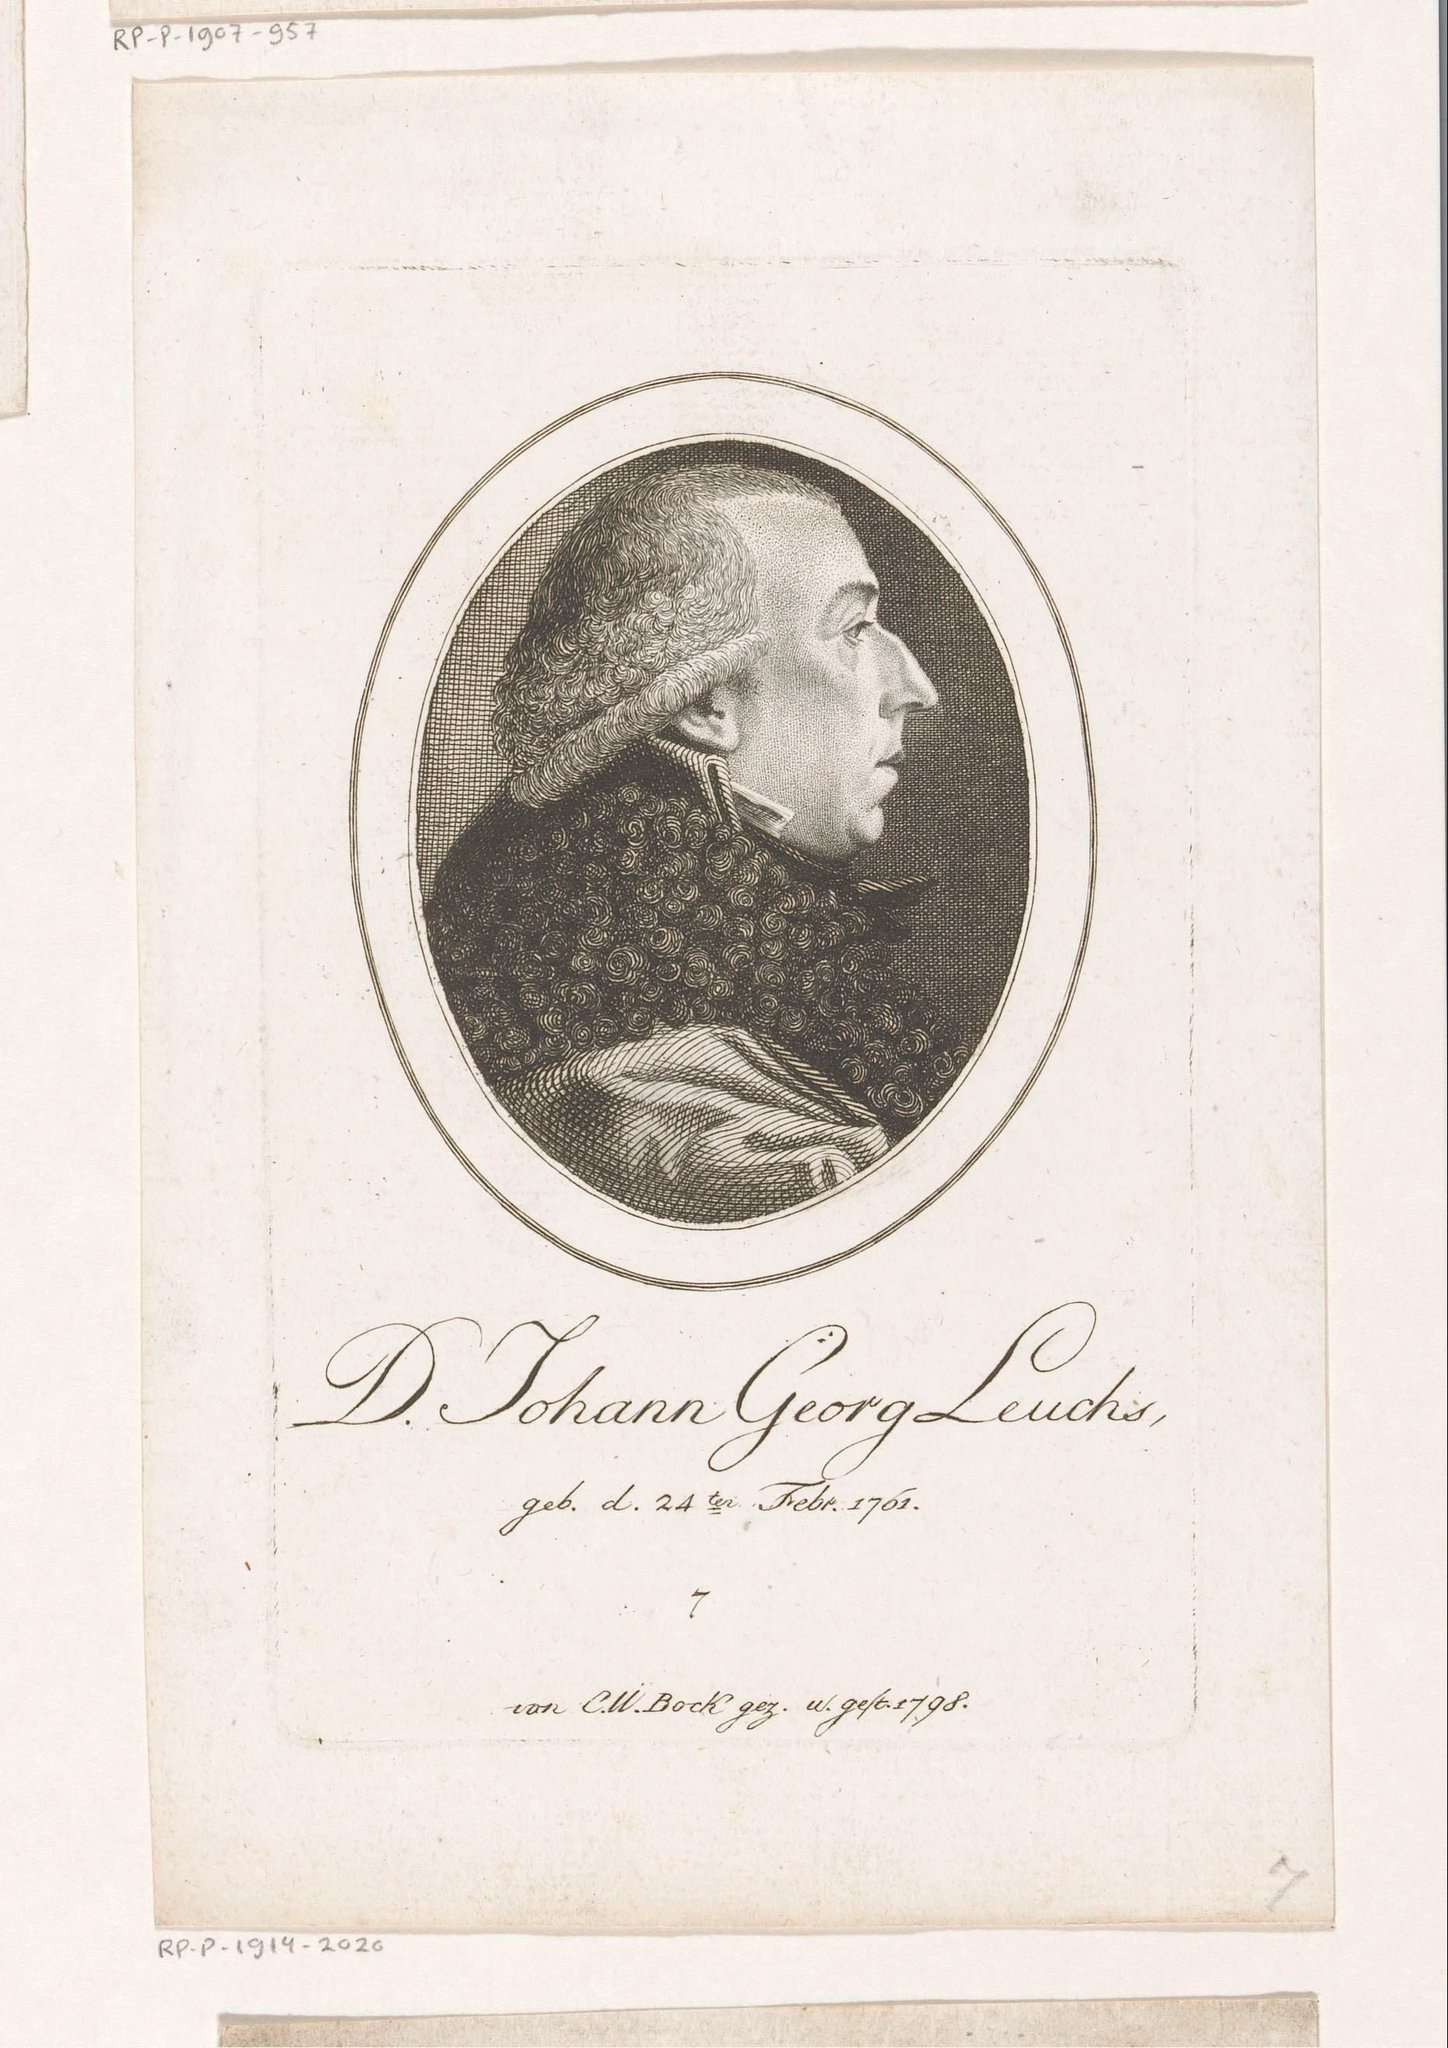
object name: print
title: Portret van Johann Georg Leuchs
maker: christoph wilhelm bock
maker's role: print maker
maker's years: 1755-1836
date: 1798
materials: paper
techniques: engraving, etching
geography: nuremberg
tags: historical persons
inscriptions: collector's mark: Lugt 2228